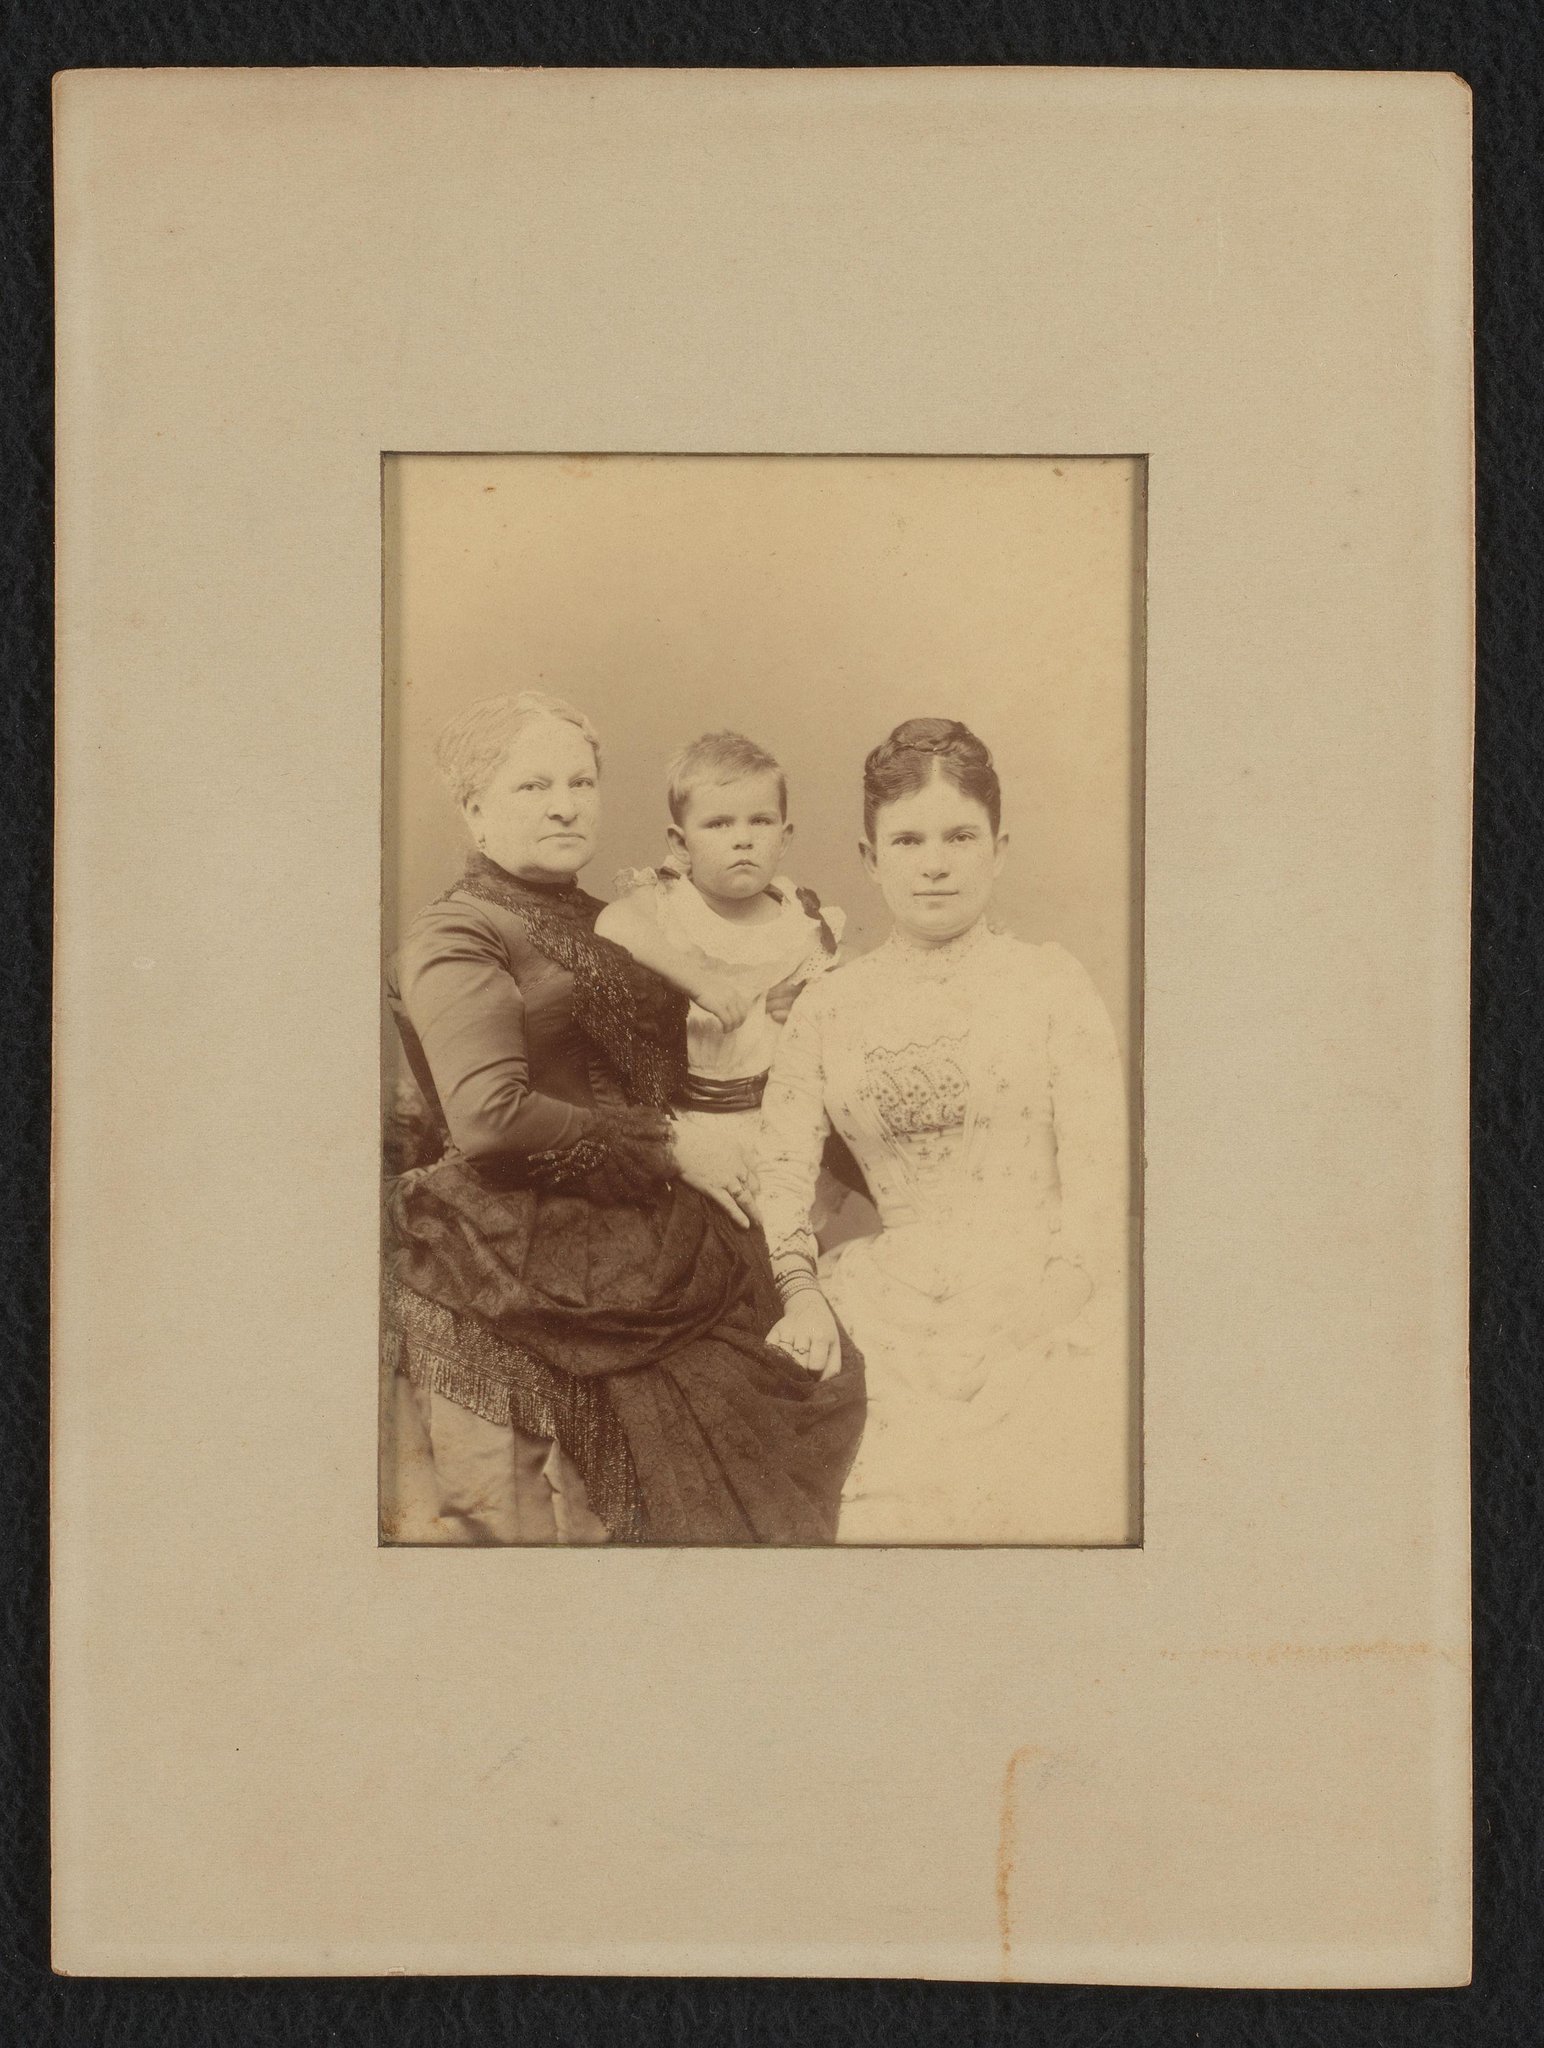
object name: cabinet photograph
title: Groepsportret van Margo Kessler-de Lange, haar dochter Go en een onbekende vrouw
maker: richard kameke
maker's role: fotograaf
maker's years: 1847-1898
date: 1887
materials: paper, cardboard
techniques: albumen print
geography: the hague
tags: margaretha jacoba johanna kessler-de lange (margo), historical persons - bb - woman, mother and daughter(s) (family group), anonymous historical person portrayed - bb - woman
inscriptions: address: ‘'s Gravenhage,/ JAVASTRAAT No 20/ bij de Scheveningscheweg.’